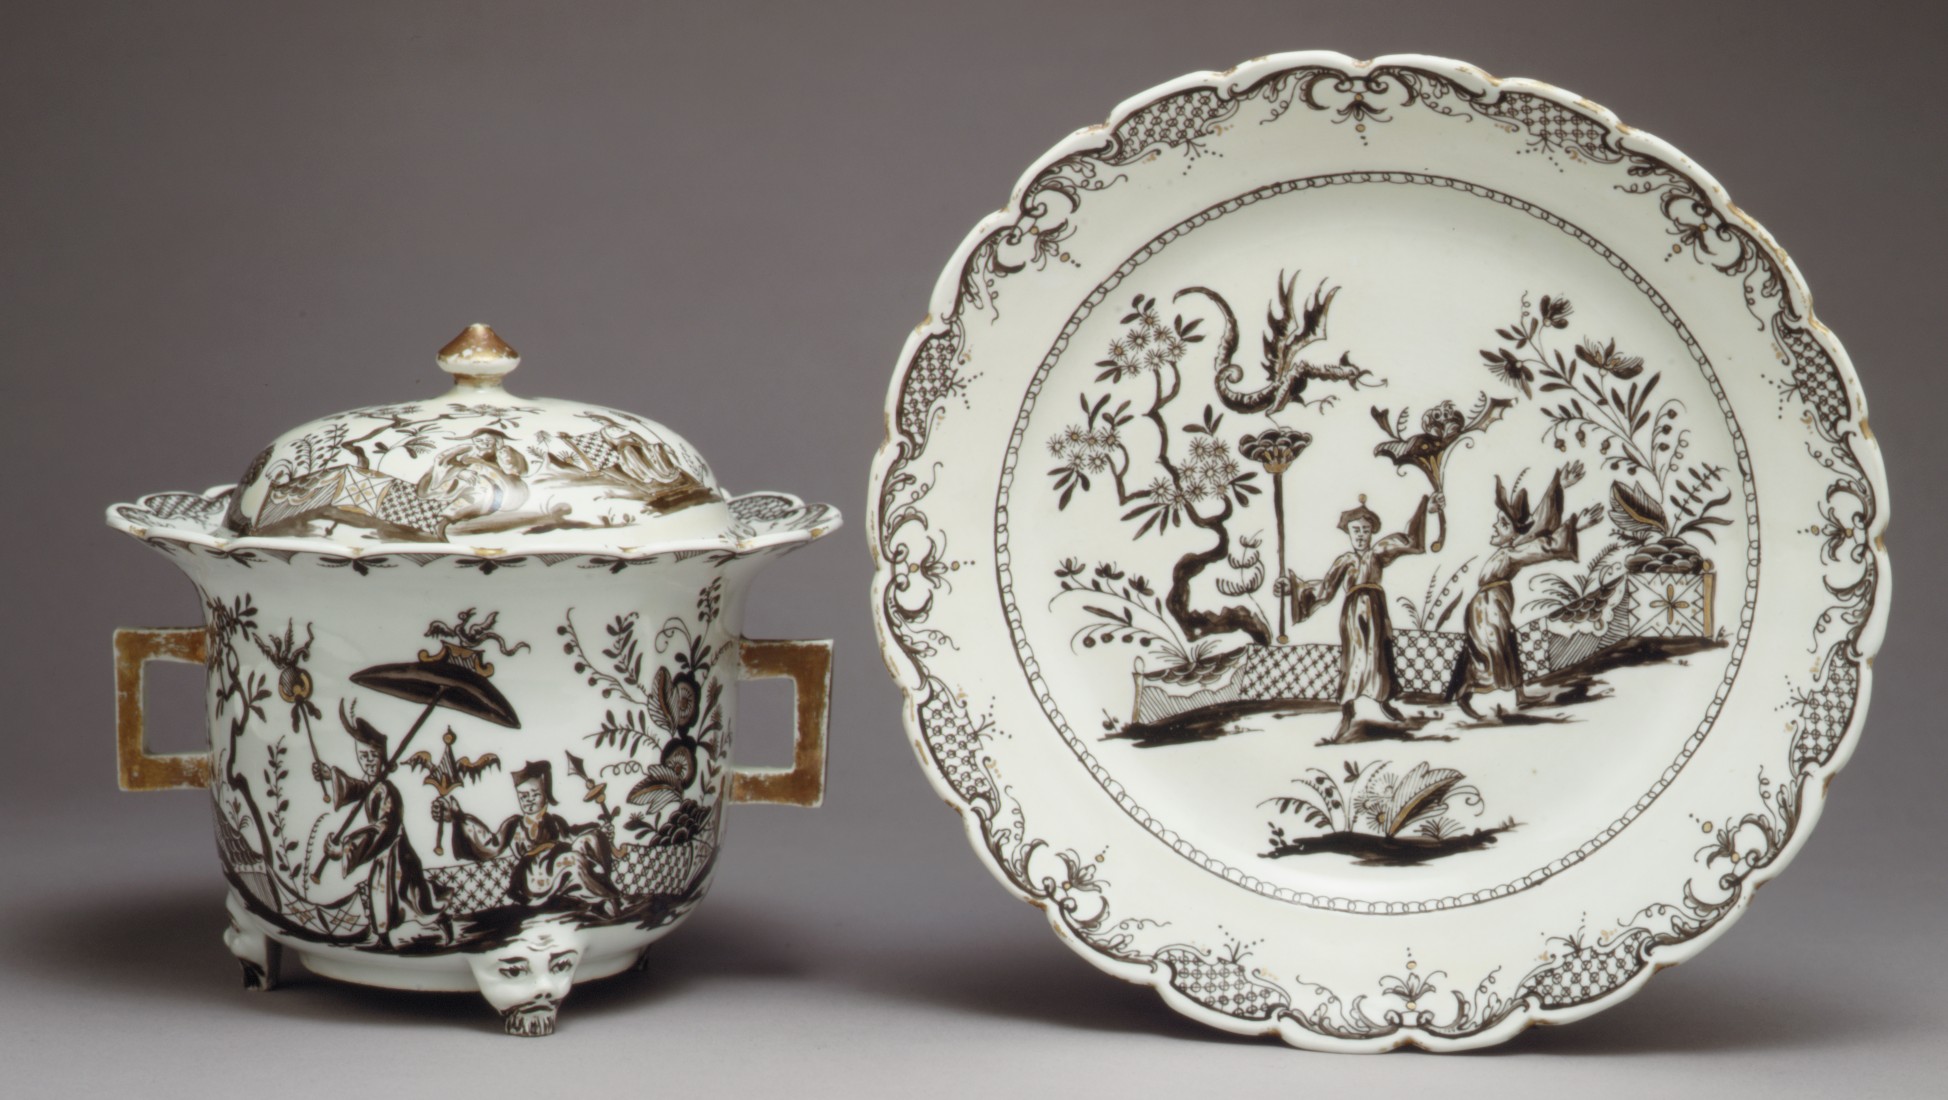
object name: ollio pot with cover and stand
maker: vienna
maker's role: manufactory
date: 1725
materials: hard paste porcelain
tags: men,dragons